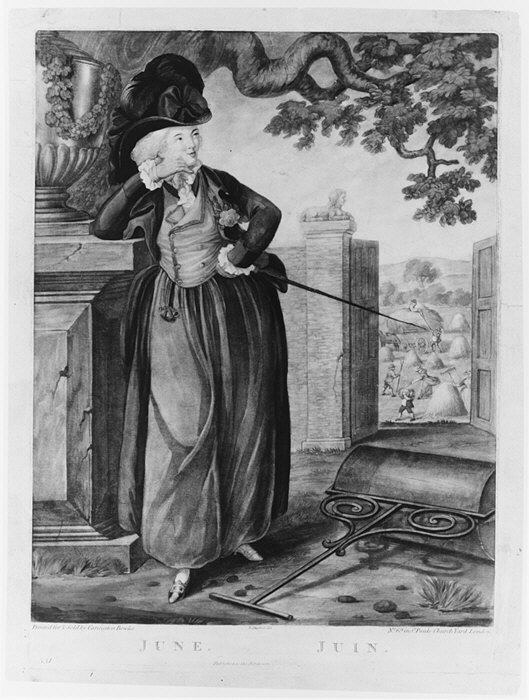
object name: print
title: June / Juin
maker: richard earlom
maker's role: engraver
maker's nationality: british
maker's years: 1743-1822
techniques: hand coloring, mezzotint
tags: women